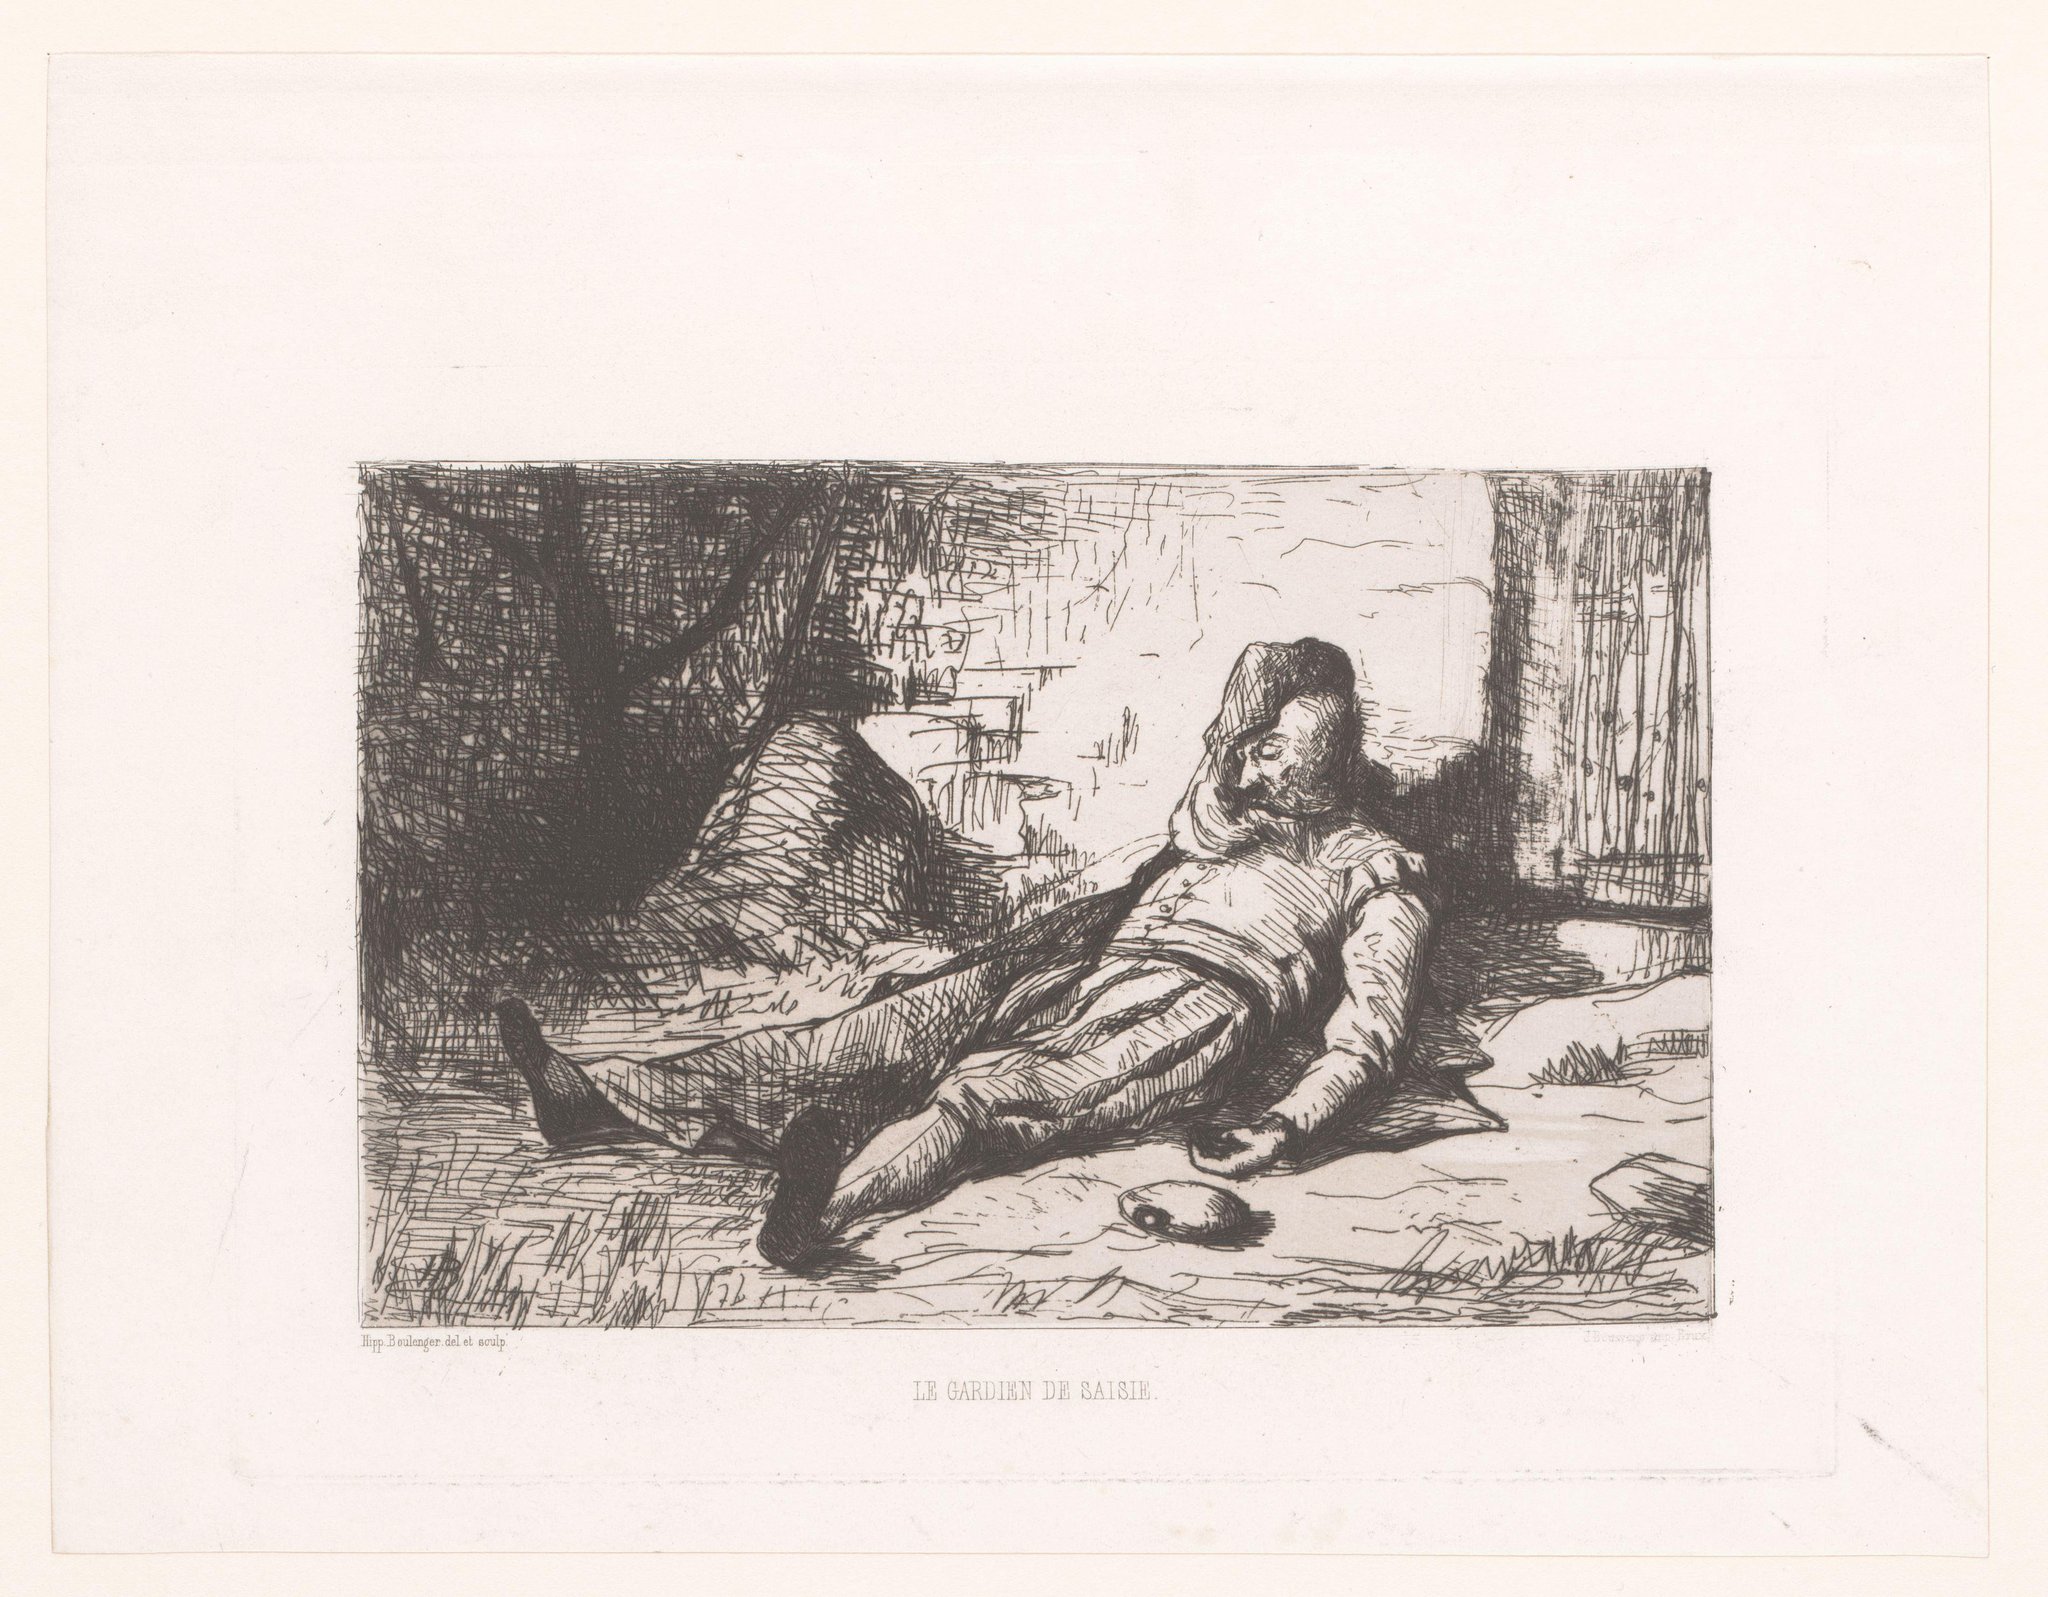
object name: book illustration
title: Slapende dronken soldaat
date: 1869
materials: paper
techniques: drypoint, etching, intaglio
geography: brussels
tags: drunkard, guard duty, keeping sentry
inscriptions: collector's mark: Lugt 2228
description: Prent uit de tweede editie van: Coster, Charles de. La légende et les aventures héoiques, joyeuses et glorieuses d'Ulenspiegel et de Lamme Goedzak (...). Parijs: Librairie Internationale, 1869.